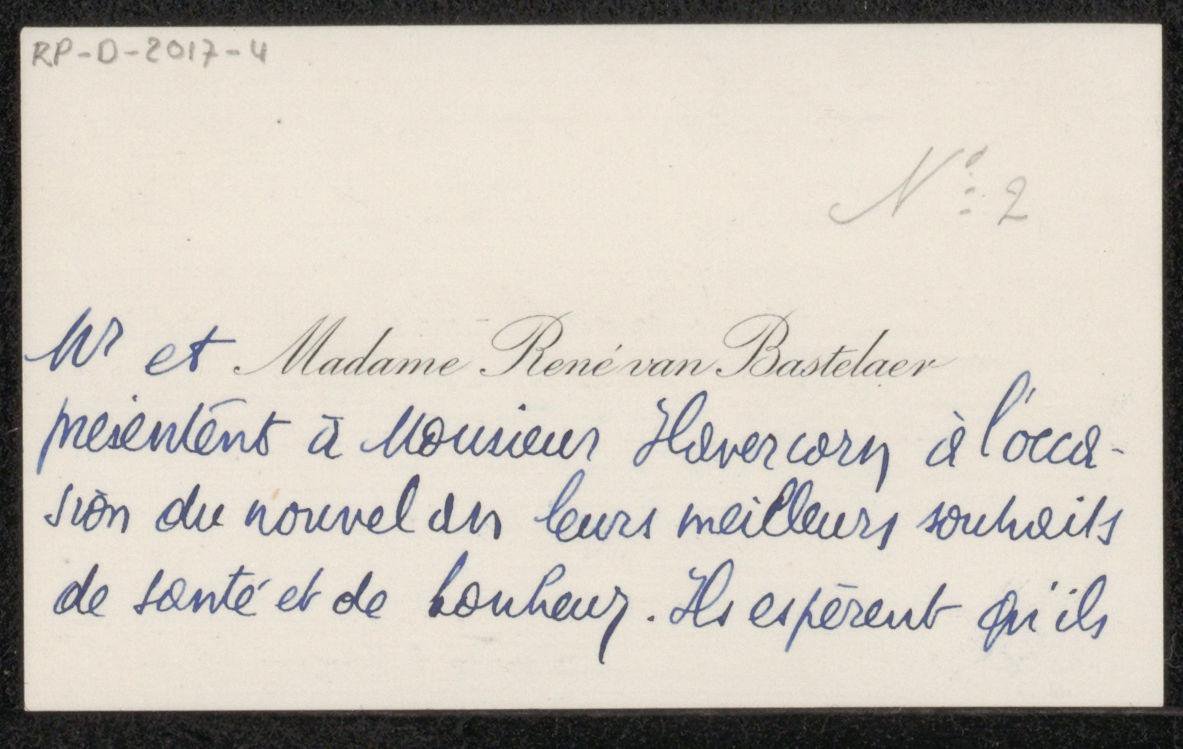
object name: visiting card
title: Visitekaartje aan Pieter Haverkorn van Rijsewijk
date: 1904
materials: cardboard, ink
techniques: pen, printing, writing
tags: antwerp, brussels, henri hymans, pieter haverkorn van rijsewijk, the graphic arts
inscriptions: collector's mark: Lugt 2233